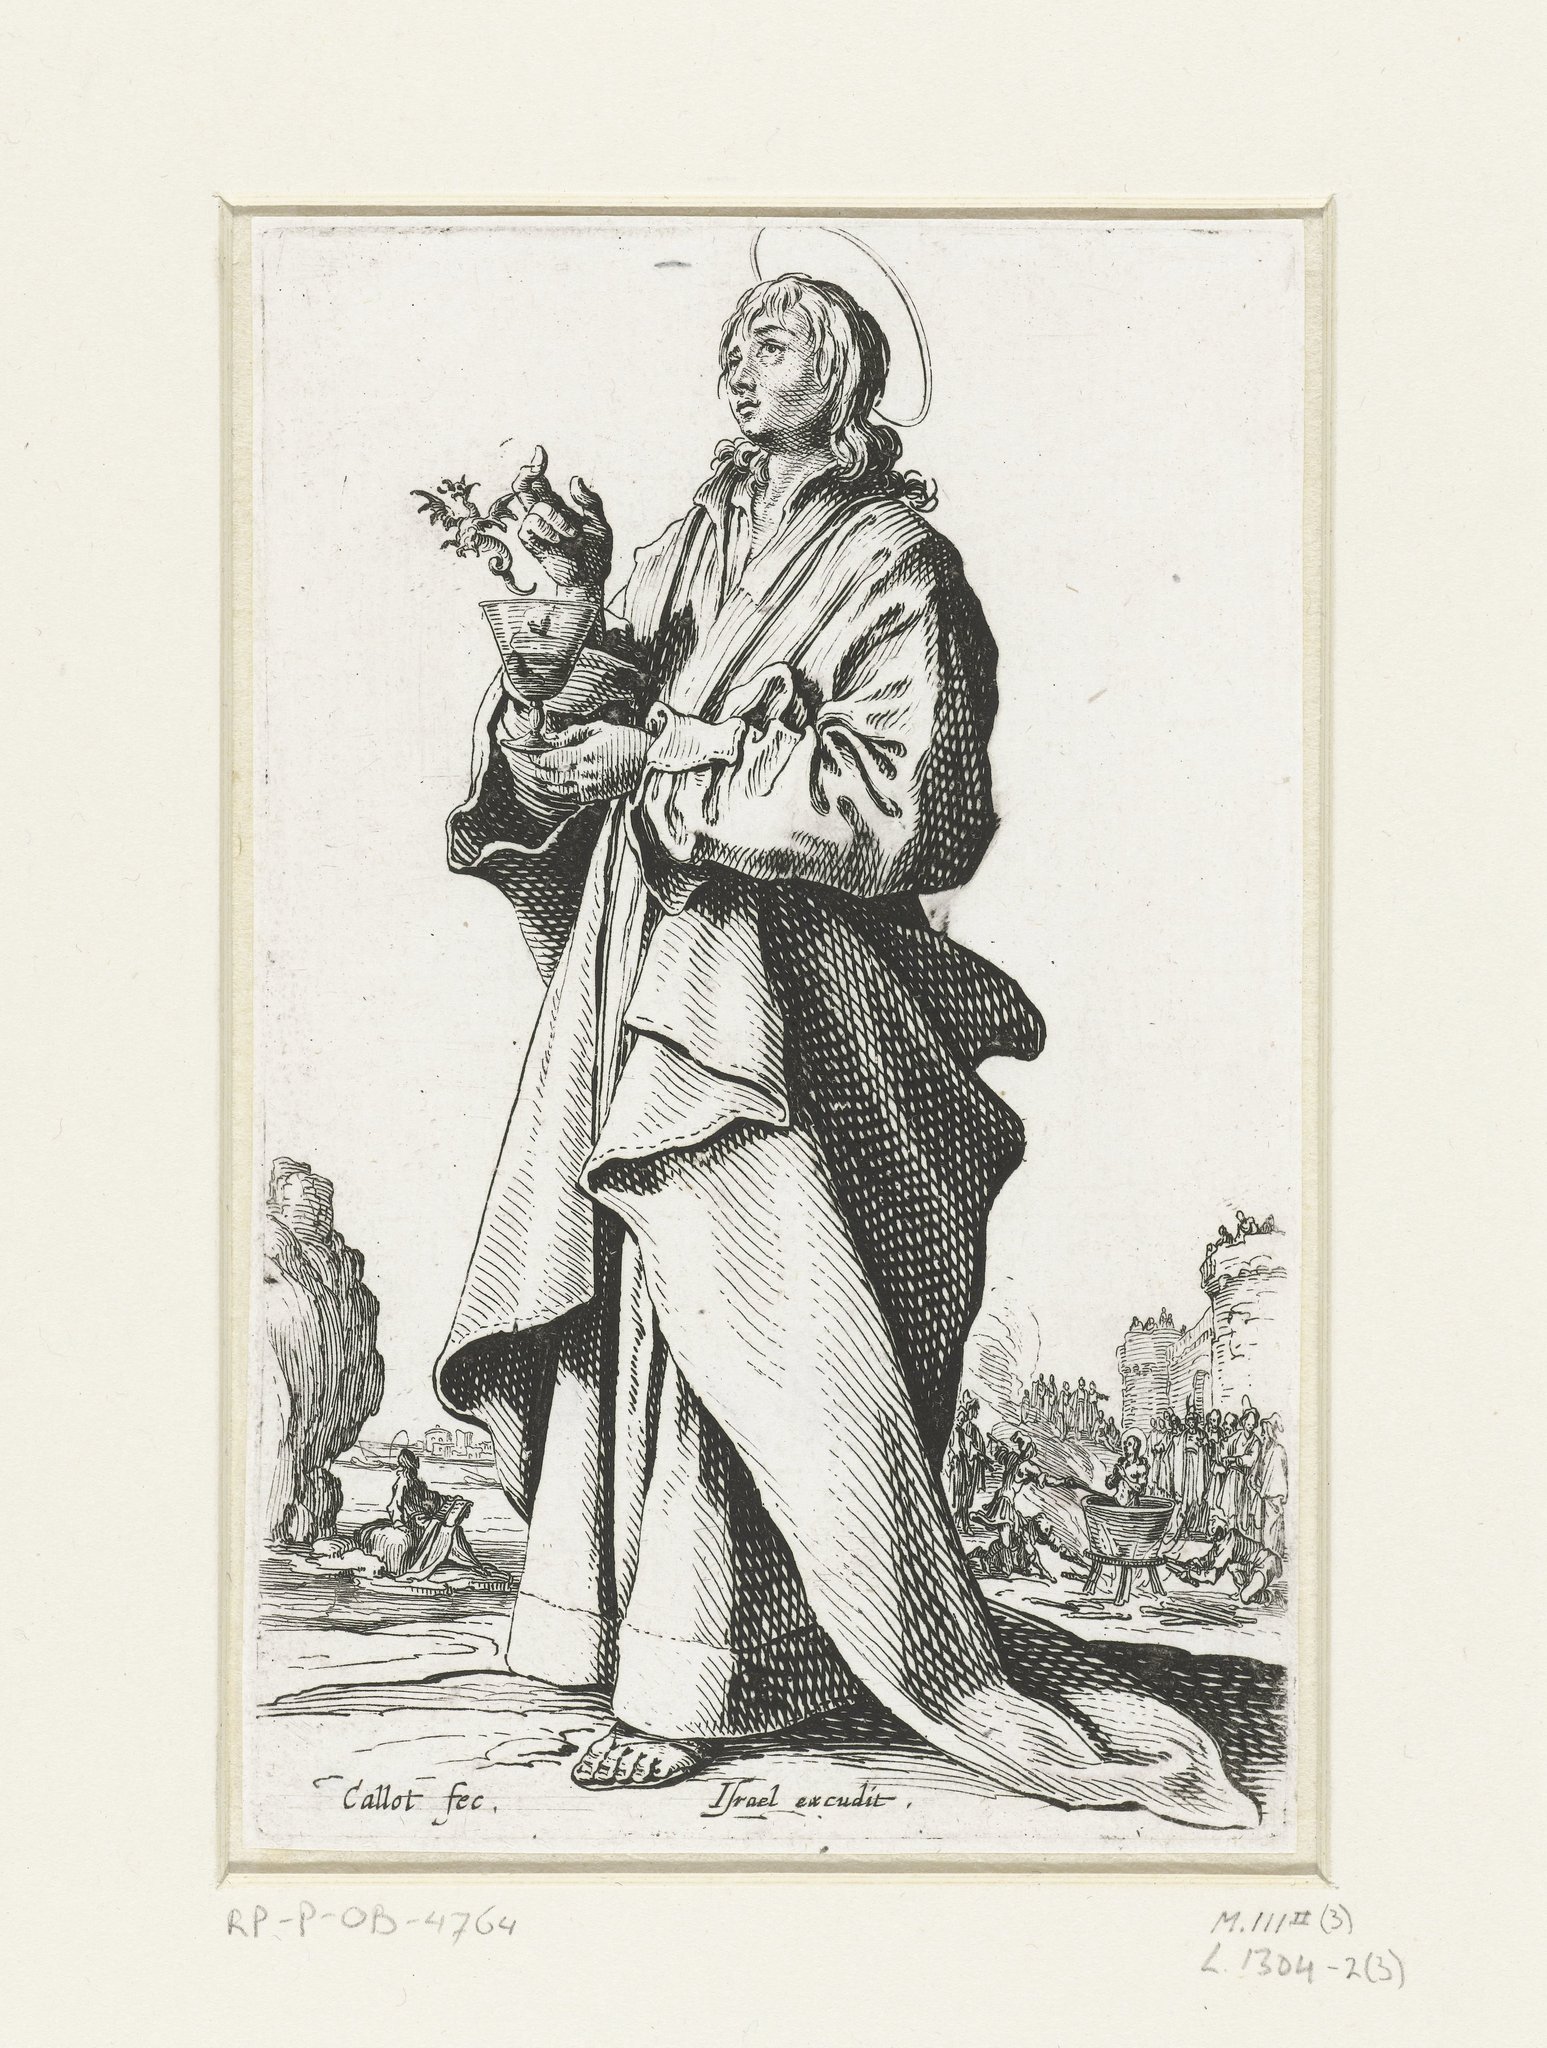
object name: print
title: Apostel Johannes de Evangelist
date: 1631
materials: paper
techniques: etching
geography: nancy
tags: the apostle john the evangelist; possible attributes: book, cauldron, chalice with snake, eagle, palm, scroll, john (writing) on the island of patmos, possibly the eagle beside him, martyrdom of john in front of the porta latina: he is put in a cauldron of boiling oil, but remains unharmed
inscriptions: collector's mark: Lugt 240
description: Johannes, ten voeten uit, een beker in de hand waaruit een draakachtig beestje opvliegt. Op de achtergrond links Johannes op het eiland Patmos; op de achtergrond rechts Johannes in een pot kokende olie. Deze prent is onderdeel van een reeks van 16 prenten, bestaande uit een titelblad en 15 portretten, voorstellende Christus, Maria en de apostelen.